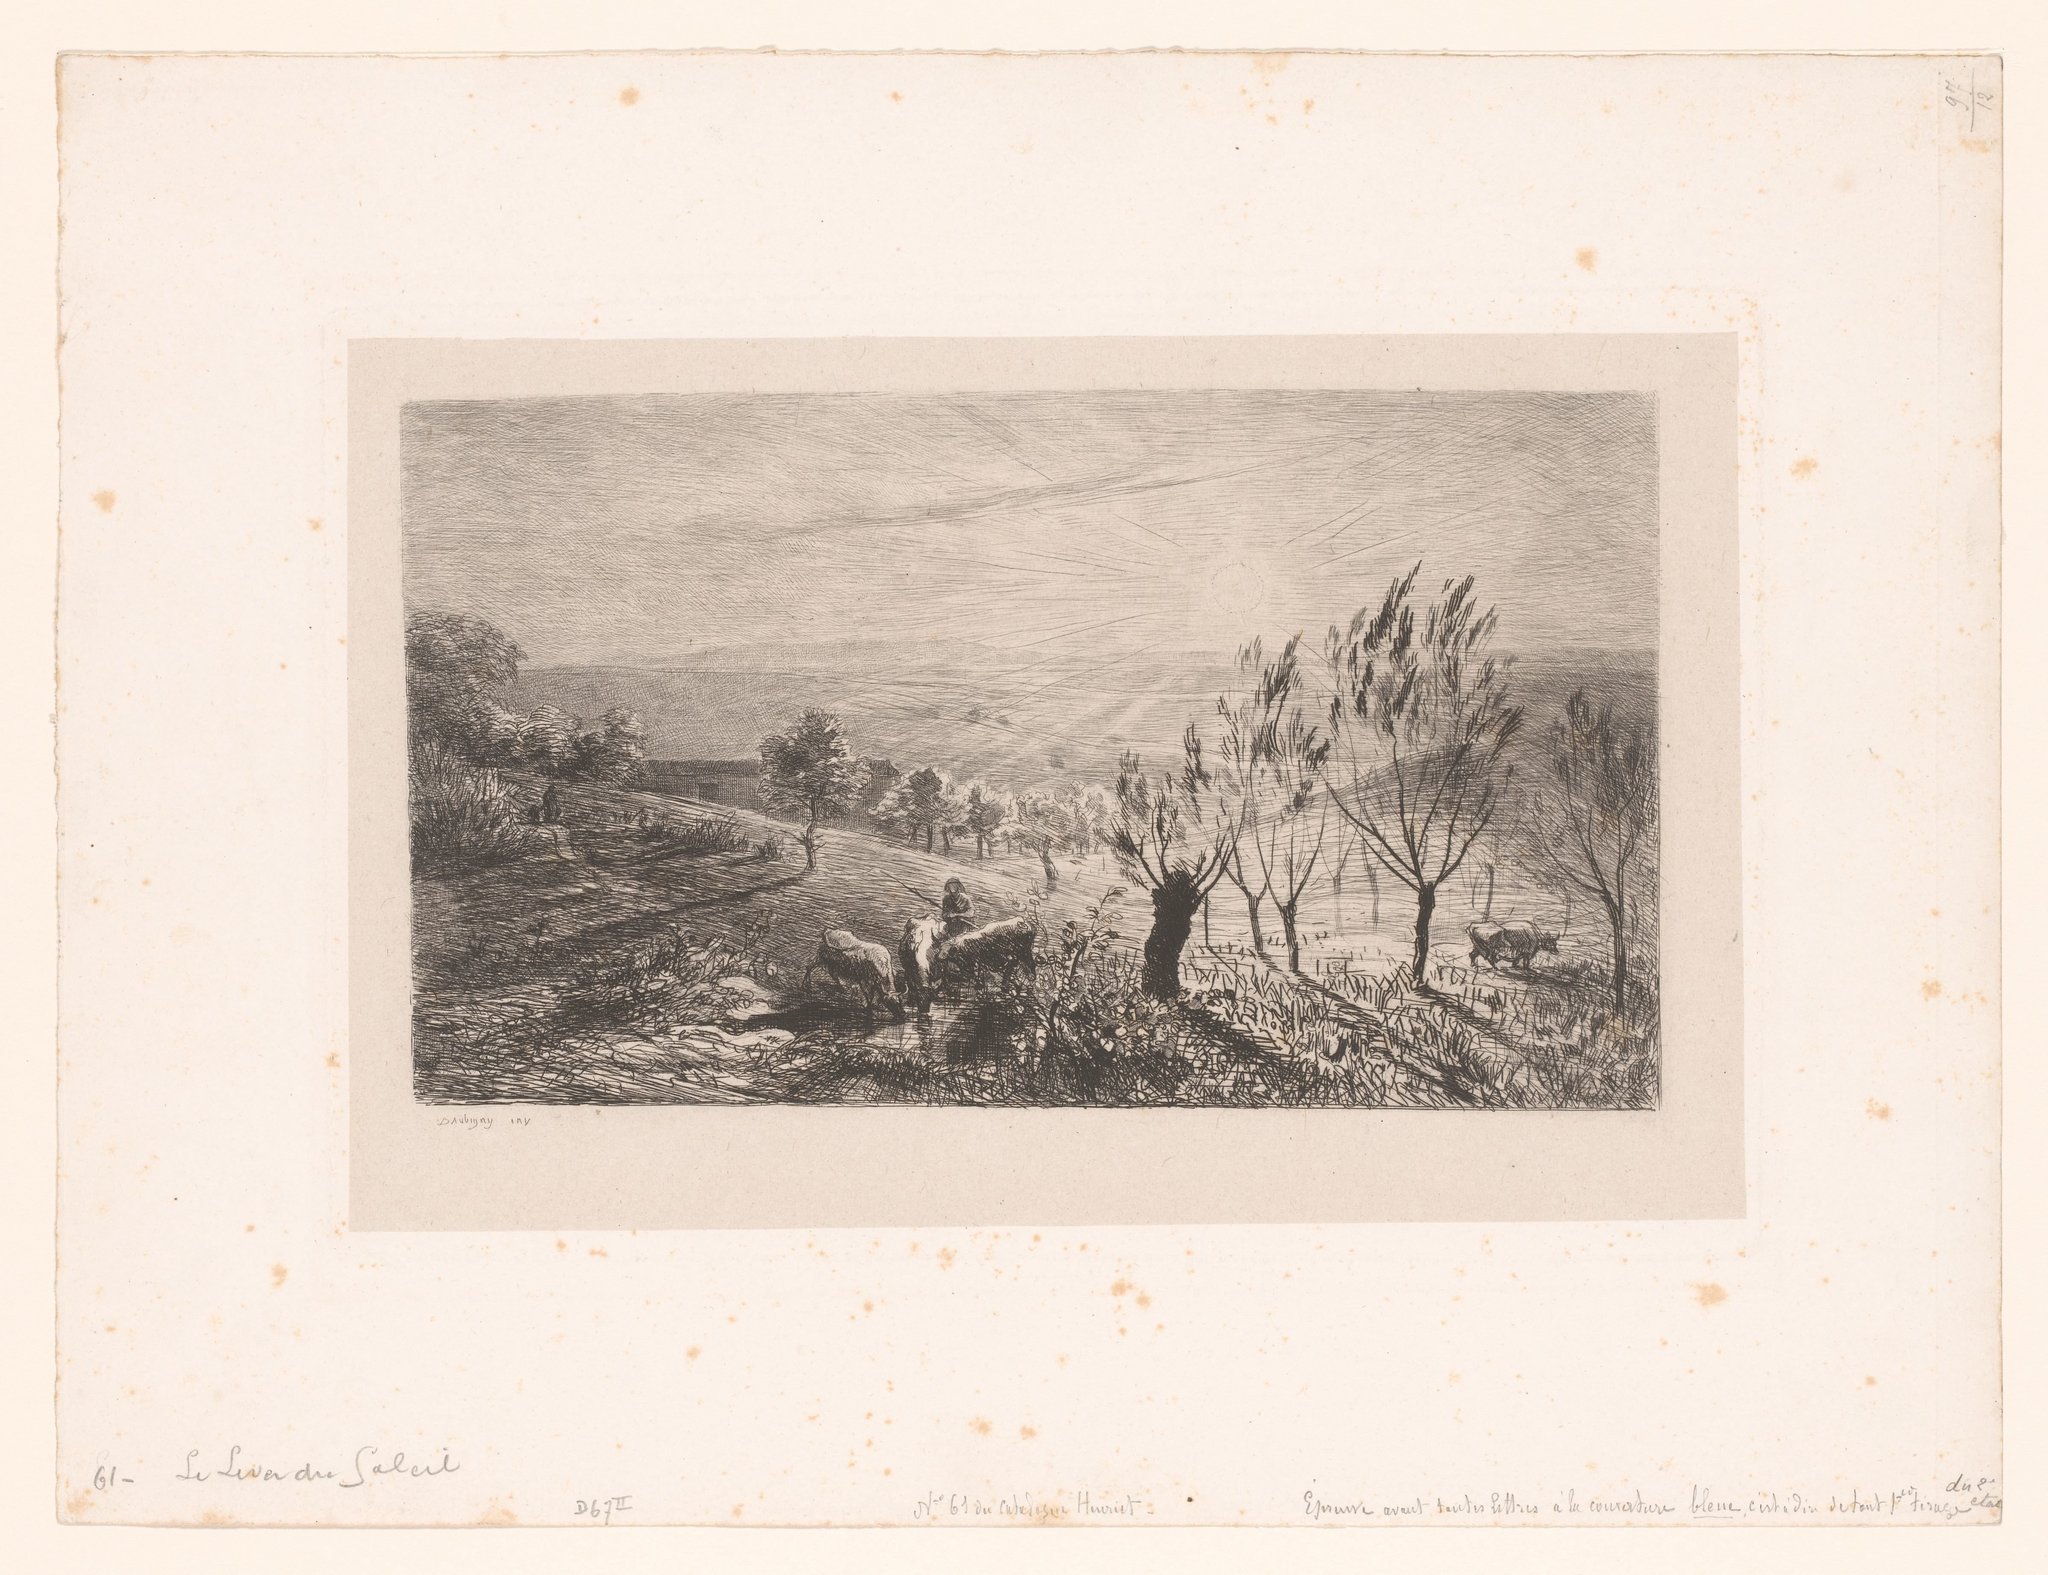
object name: print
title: Landschap met zonsopgang en veehoeder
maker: charles-françois daubigny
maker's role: draughtsman, painter, print maker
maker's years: 1817-1878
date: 1850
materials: paper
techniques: drypoint, engraving, etching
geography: france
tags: landscapes, herding, herdsman, herdswoman, shepherd, shepherdess, cowherd, etc., herd, flock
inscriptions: collector's mark: Lugt 2228